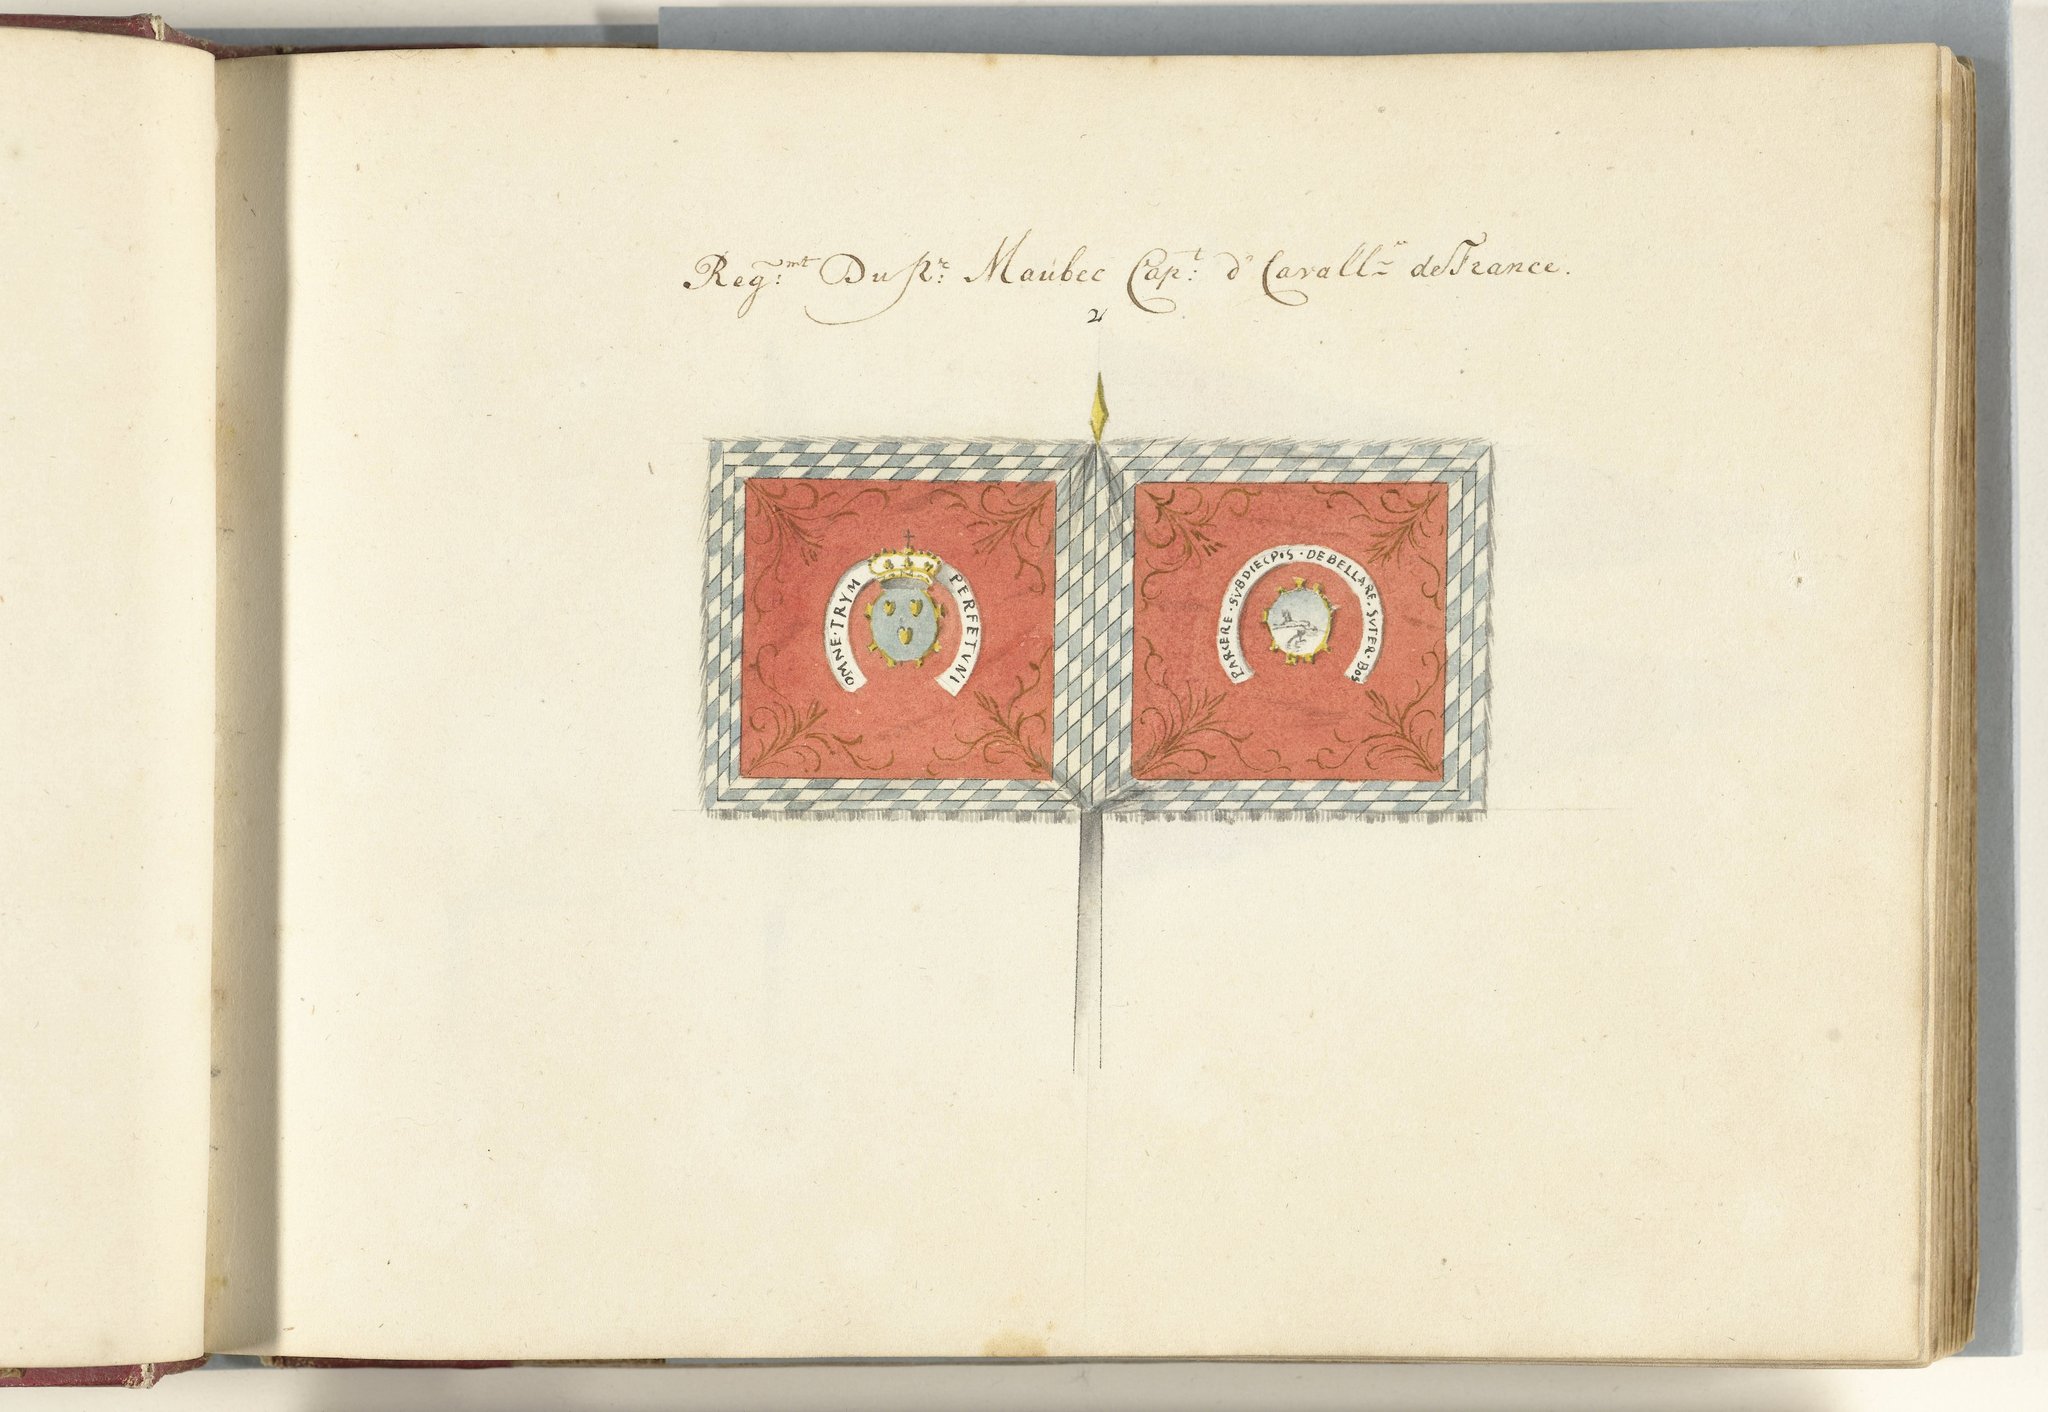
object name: drawing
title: Frans standaard veroverd in de slag bij Ekeren, 1703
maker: Anonymous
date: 1713-1720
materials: paper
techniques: drawing, writing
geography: northern netherlands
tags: (military) flags and standards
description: Frans standaard veroverd in de slag bij Ekeren, 1703. In het boek met tekeningen van Franse vaandels, standaarden en pauken, veroverd tijdens de Spaanse Successieoorlog (1701-1713).